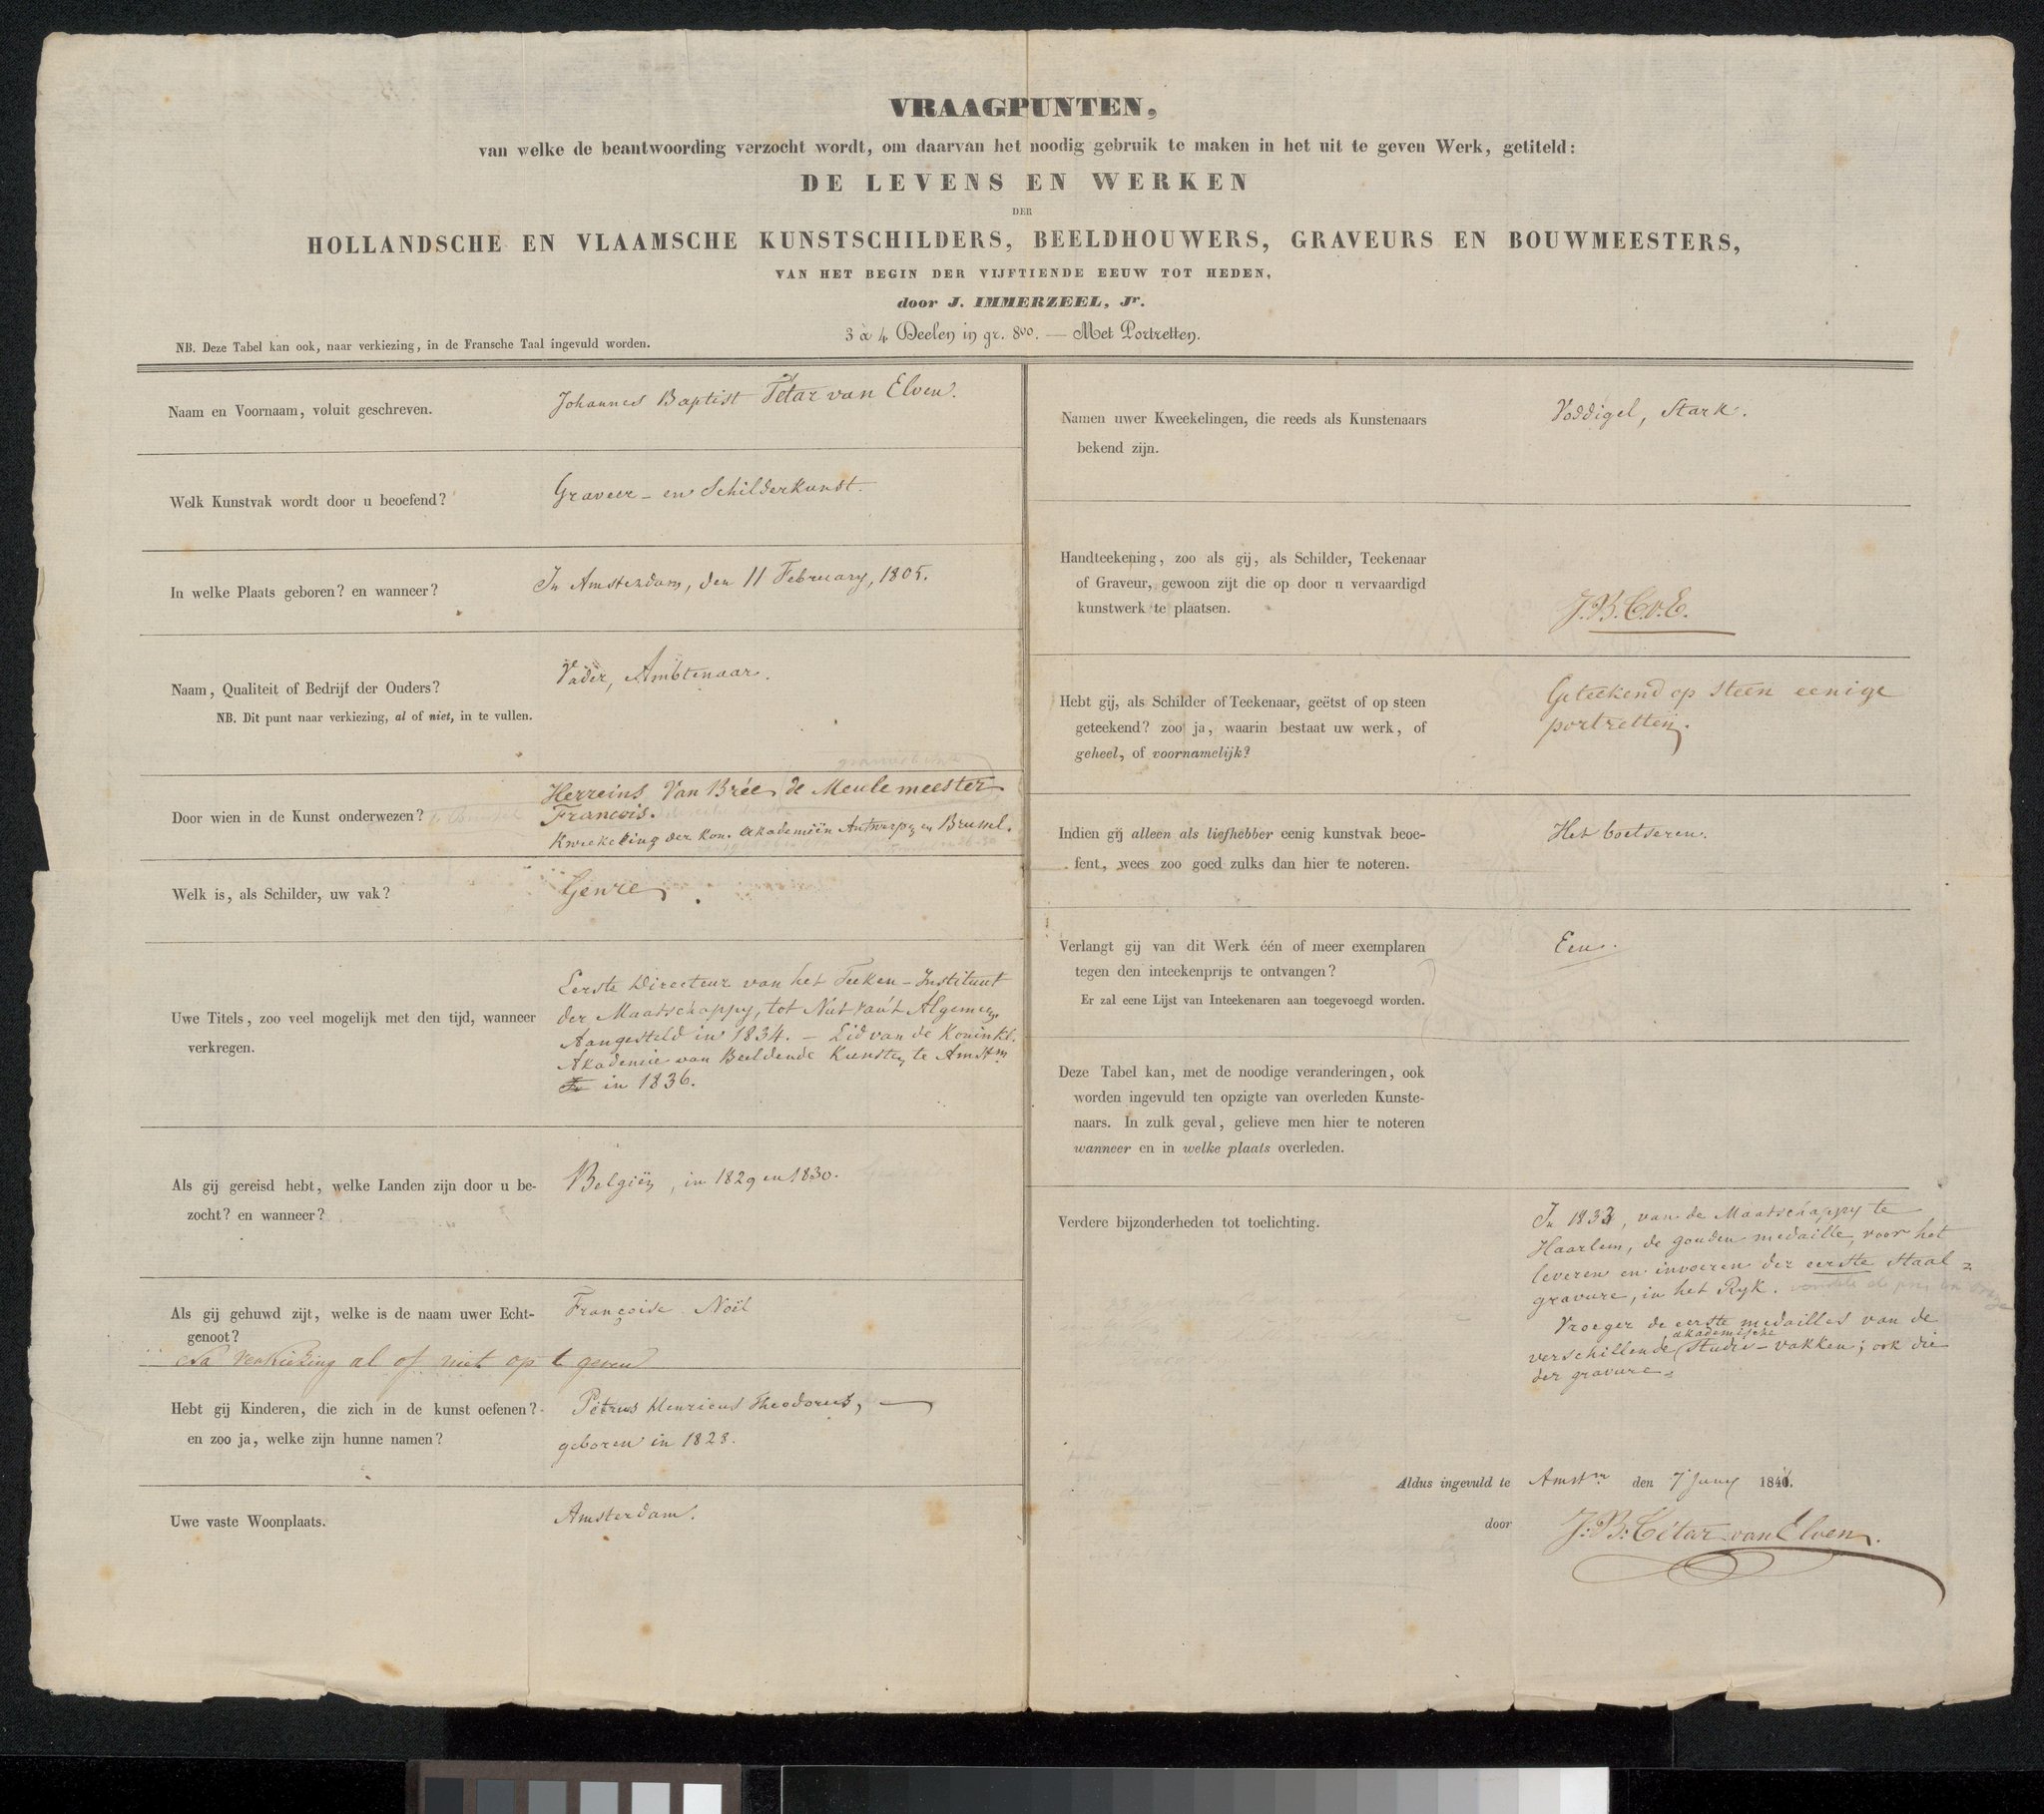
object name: manuscript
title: Enquêteformulier ingevuld door Jan Baptist Tetar van Elven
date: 1841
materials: ink, paper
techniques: pen, printing, writing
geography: amsterdam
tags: amsterdam, voorschoten, jan baptist tetar van elven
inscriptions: inscription: ‘Vraagpunten,/ van welke de beantwoording verzocht wordt, om daarvan het noodig gebruik te maken in het uit te geven Werk, getiteld: De levens en werken/ der Hollandsche en Vlaamsche kunstschilders, beeldhouwers,/ graveurs en bouwmeesters, van het begin der vijftiende eeuw tot heden/ door J. Immerzeel, Jr.’, watermark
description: Opgenomen in: Immerzeel, J. Jr., De levens en werken der Hollandsche en Vlaamsche kunstschilders, beeldhouwers, graveurs en bouwmeesters, van het begin der vijftiende eeuw tot heden, Amsterdam: J.C. van Kesteren, 1842-1843.